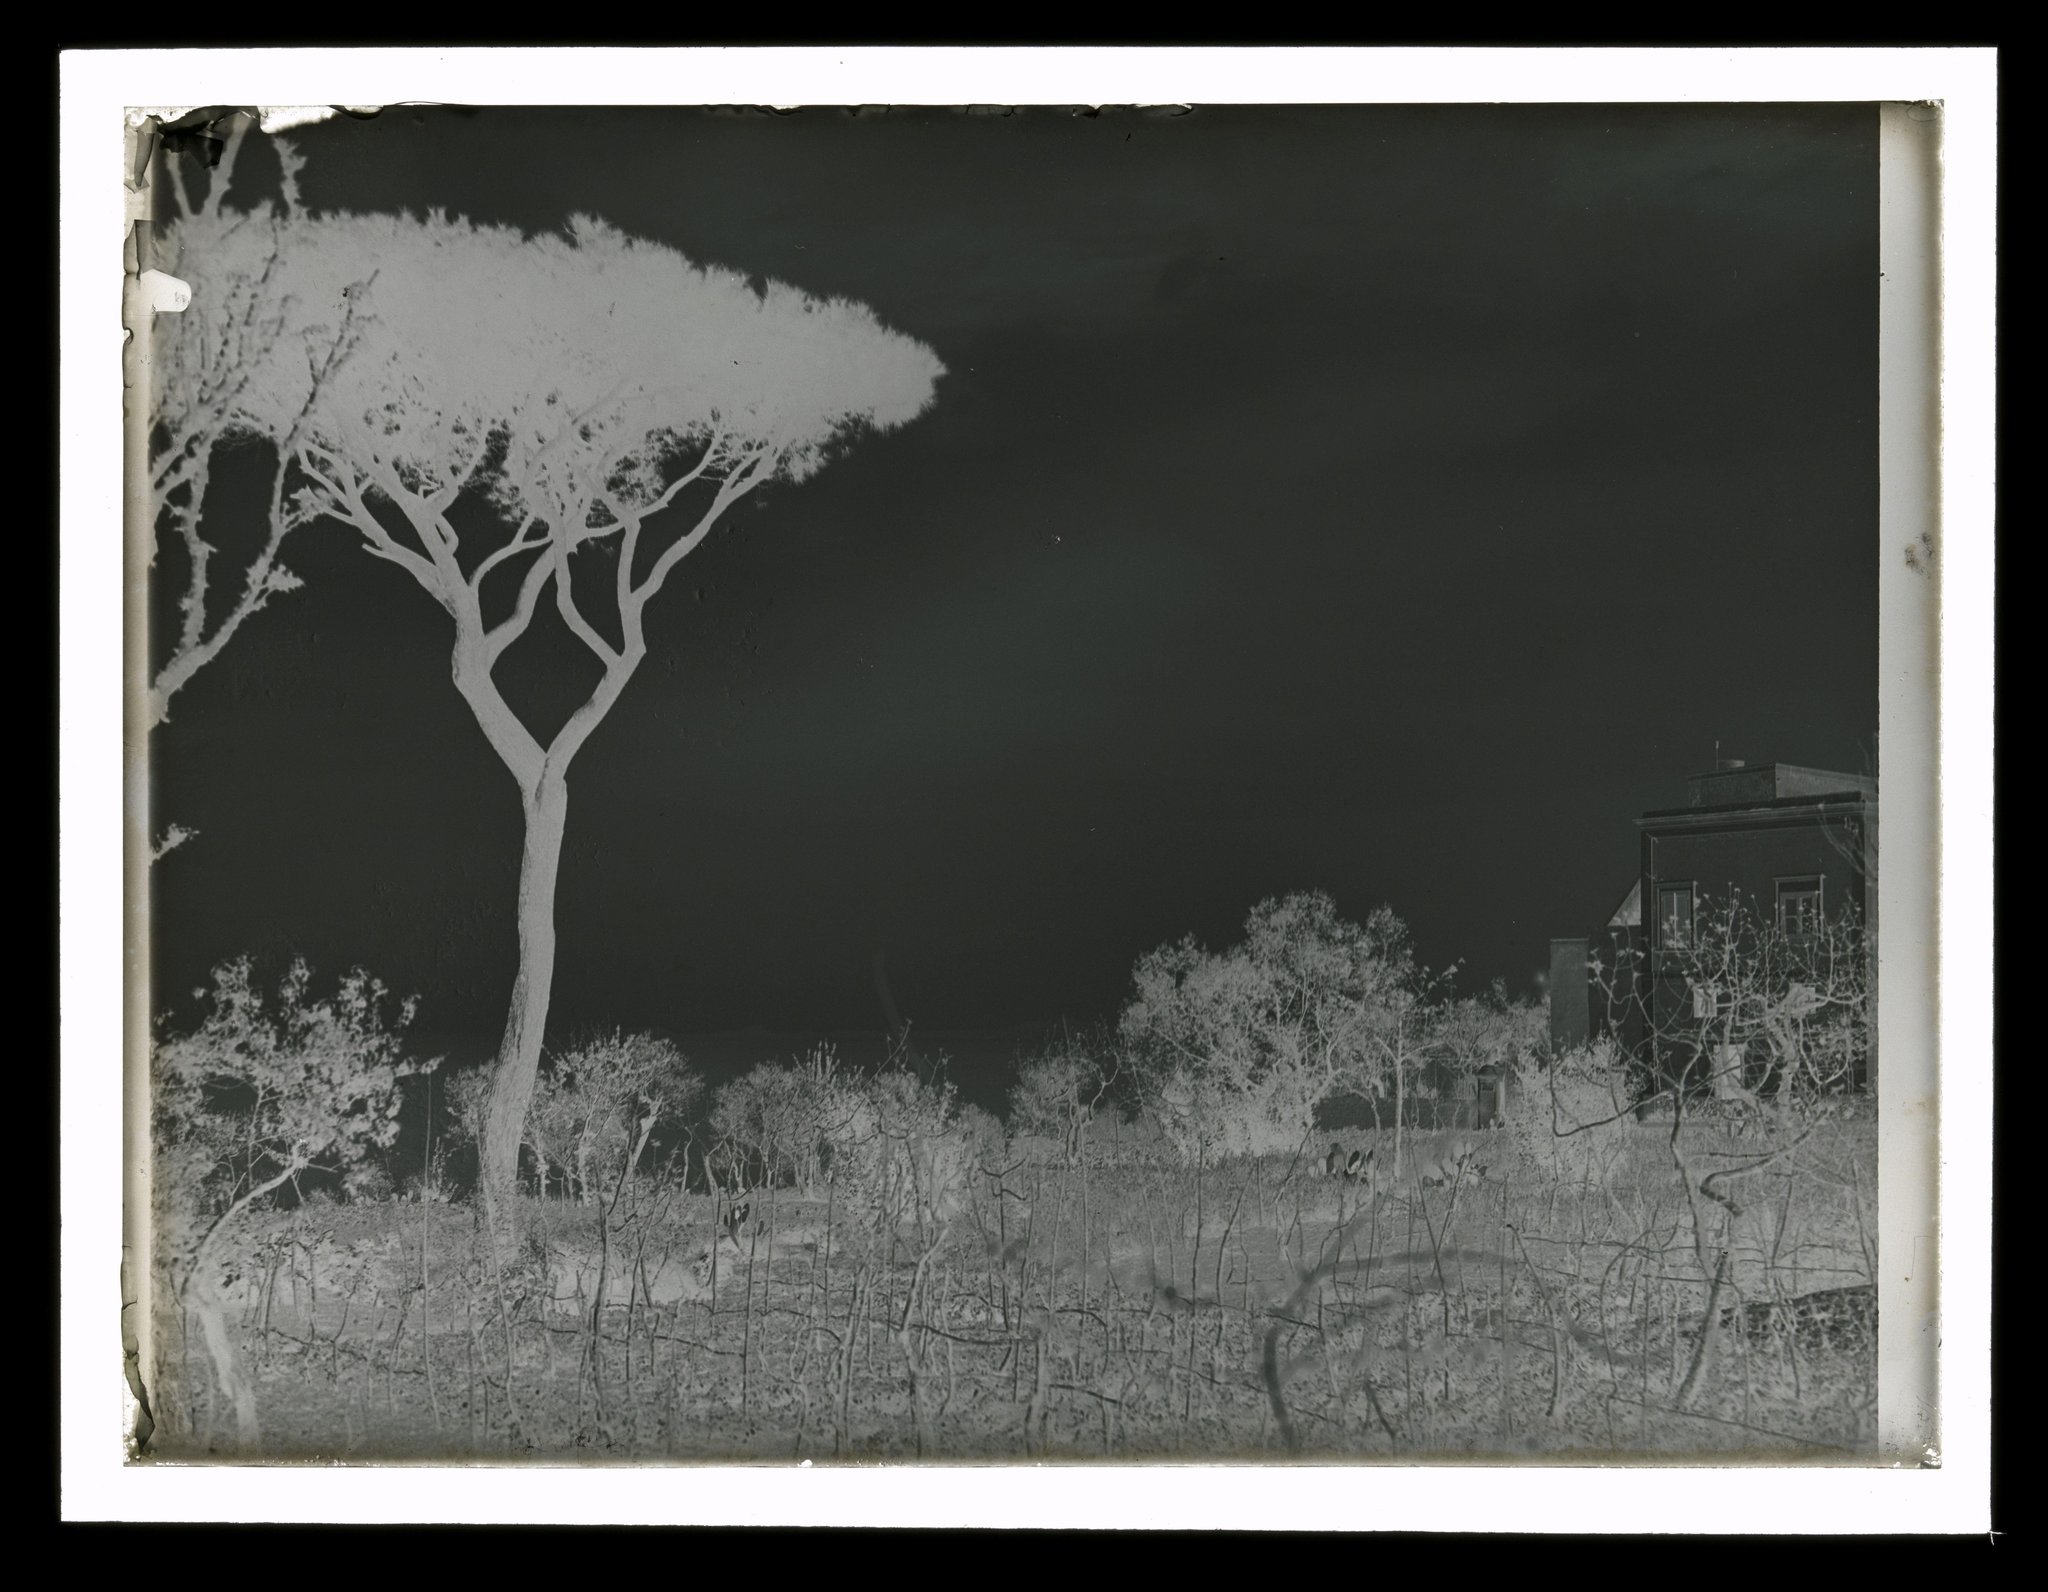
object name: glasnegatief, glasplaatnegatief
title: Landschap met pijnboom en een gebouw, Sorrento of Capri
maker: Anonymous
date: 1907-1935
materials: glass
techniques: gelatin glass negative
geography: campania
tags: trees: pine, farm or solitary house in landscape, campania